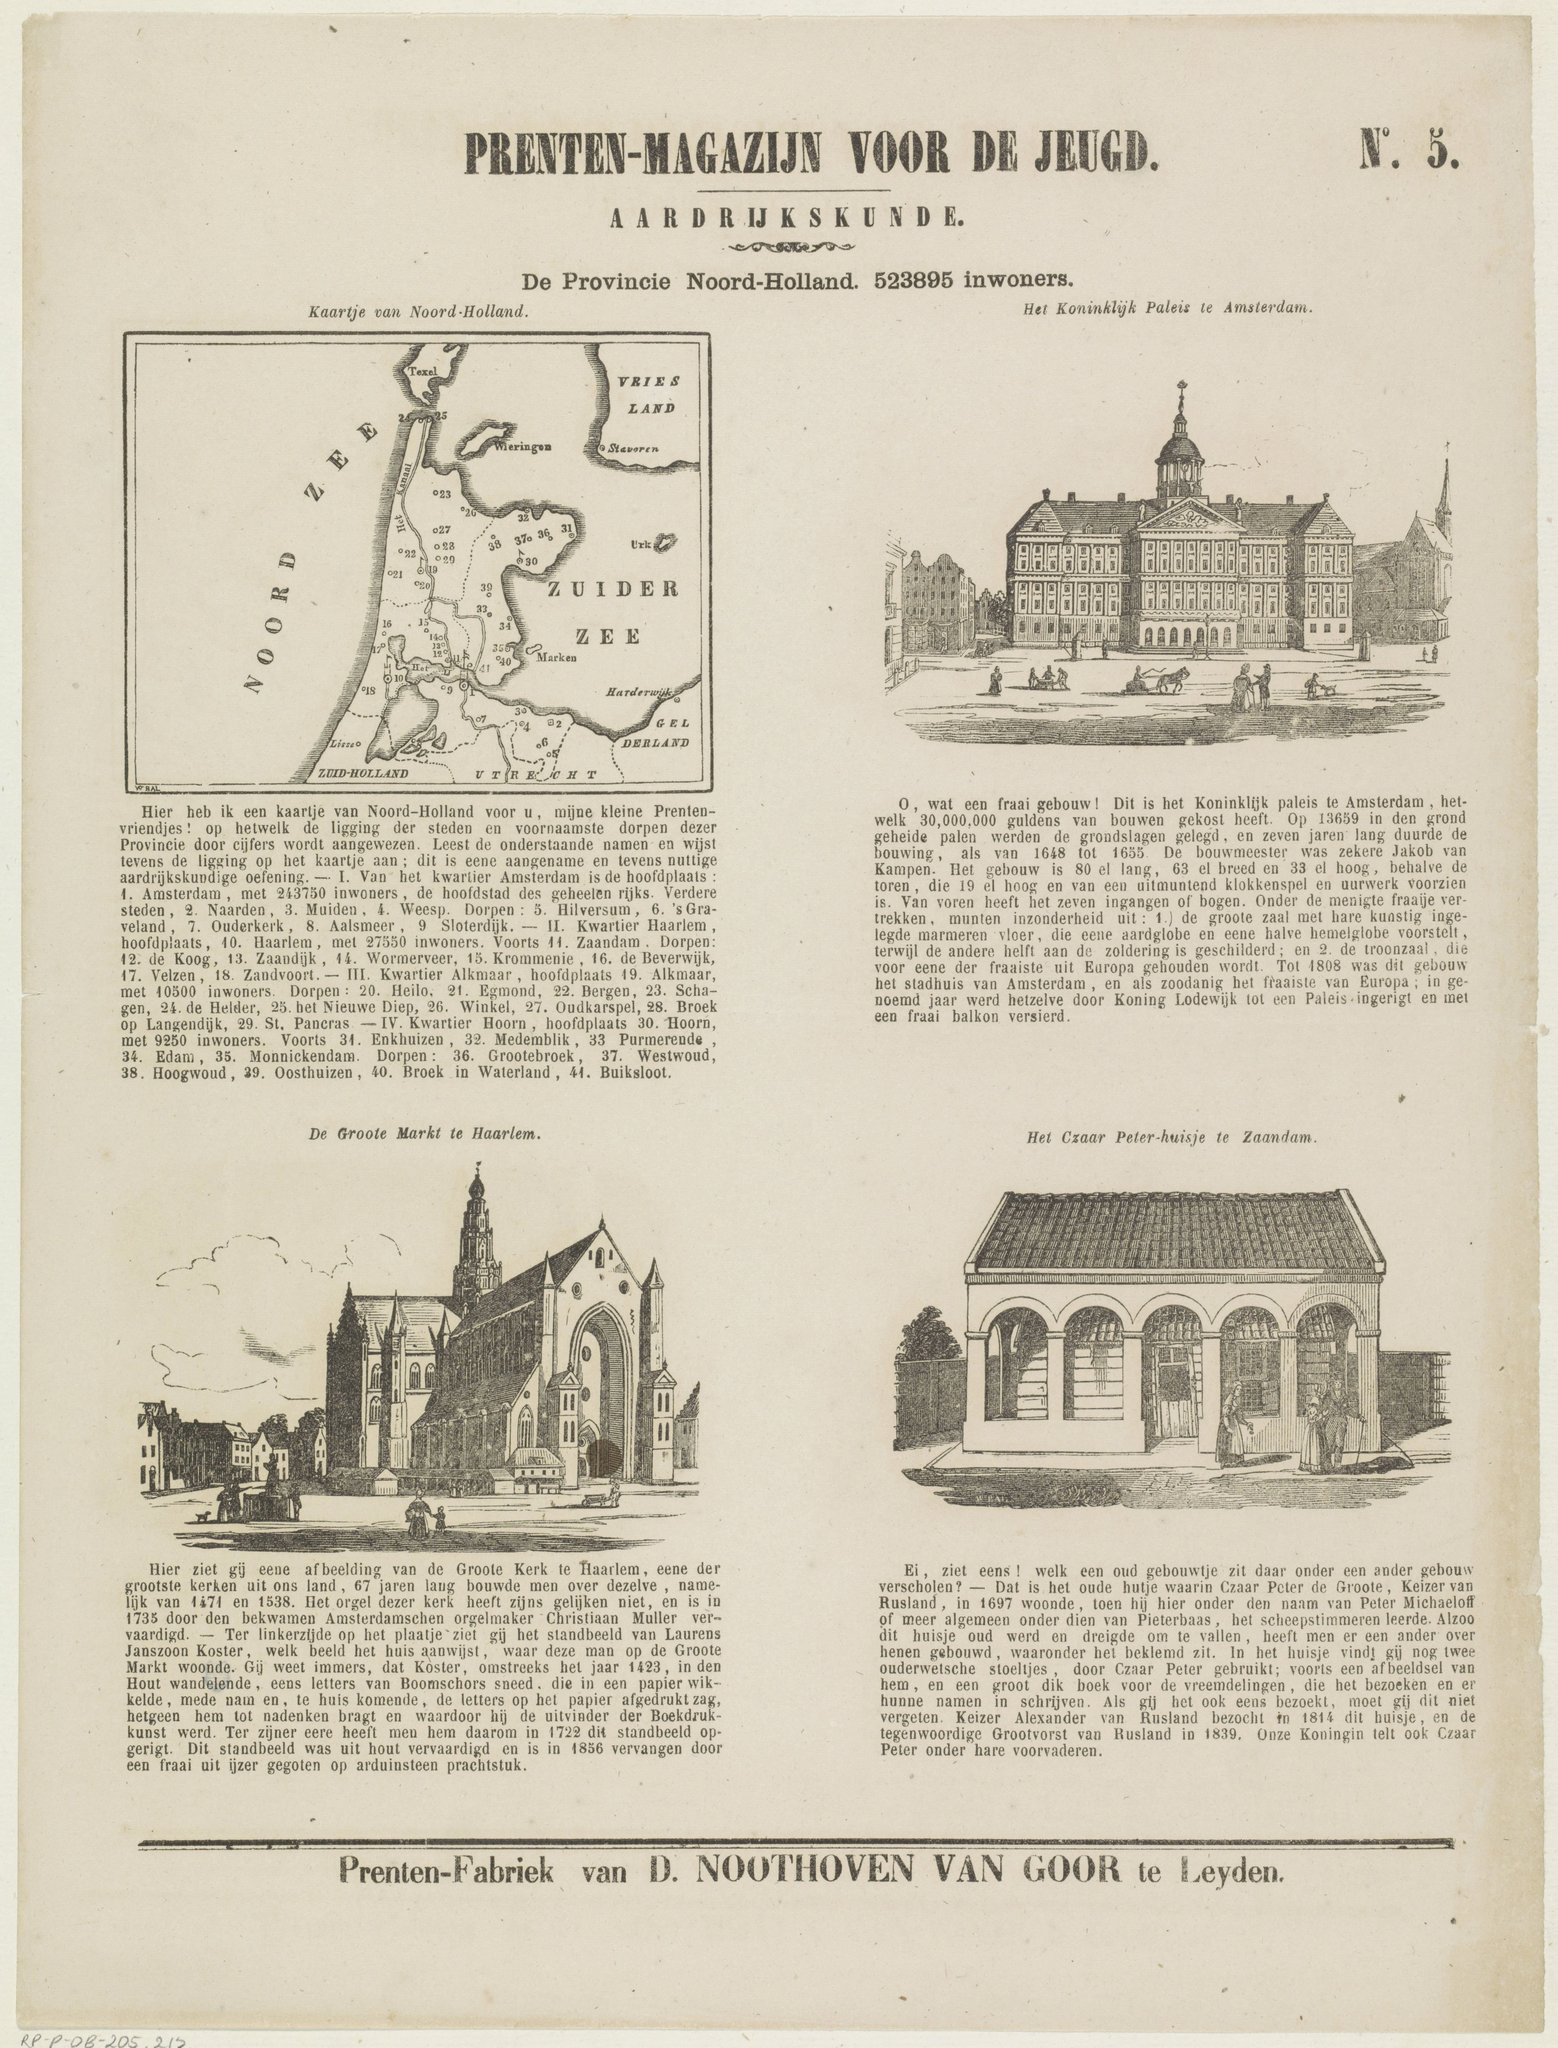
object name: print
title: Aardrijkskunde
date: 1850-1881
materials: paper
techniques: letterpress printing, engraving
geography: leiden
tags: maps, atlases, palace, roman catholic church, royal palace of amsterdam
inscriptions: collector's mark: Lugt 2760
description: Blad met 4 voorstellingen over de provincie Noord-Holland met een kaart en belangrijke gebouwen: het Paleis op de Dam te Amsterdam, de Grote Markt in Haarlem en het Czaar Peterhuisje te Zaandam. Boven elke voorstelling een titel en onder elke voorstelling twaalf tot achttien regels tekst. Genummerd rechtsboven: No. 5.